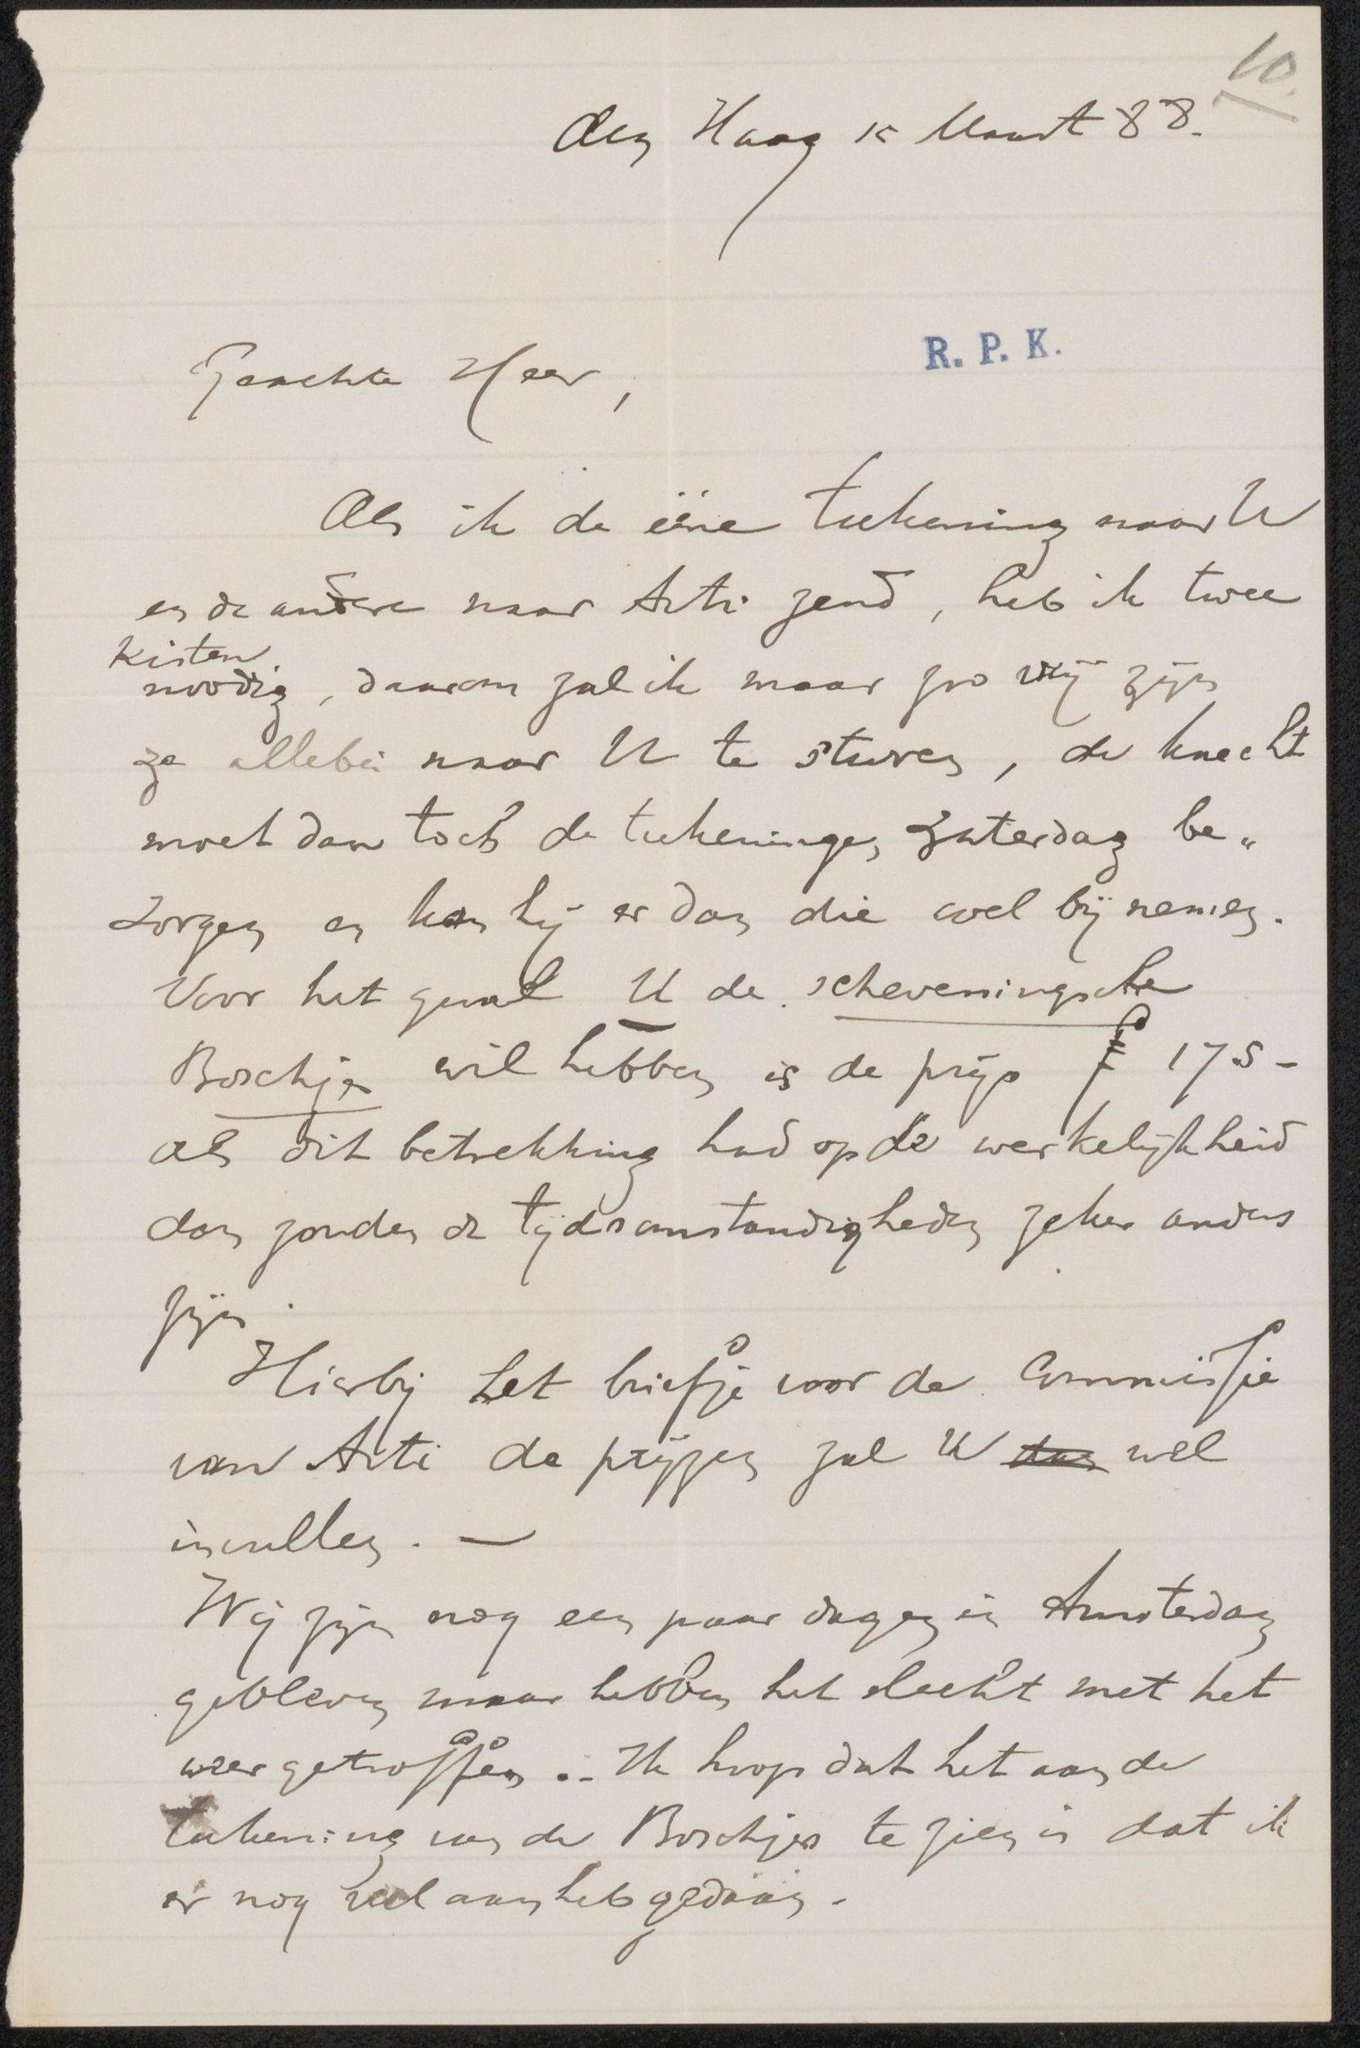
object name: letter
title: Brief aan Frans Buffa en Zonen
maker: willem bastiaan tholen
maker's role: draughtsman, painter, print maker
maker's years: 1860-1931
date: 1888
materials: ink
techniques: pen, writing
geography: the hague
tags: art trade, art shop, drawing, money, amsterdam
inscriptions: collector's mark: Lugt 2233